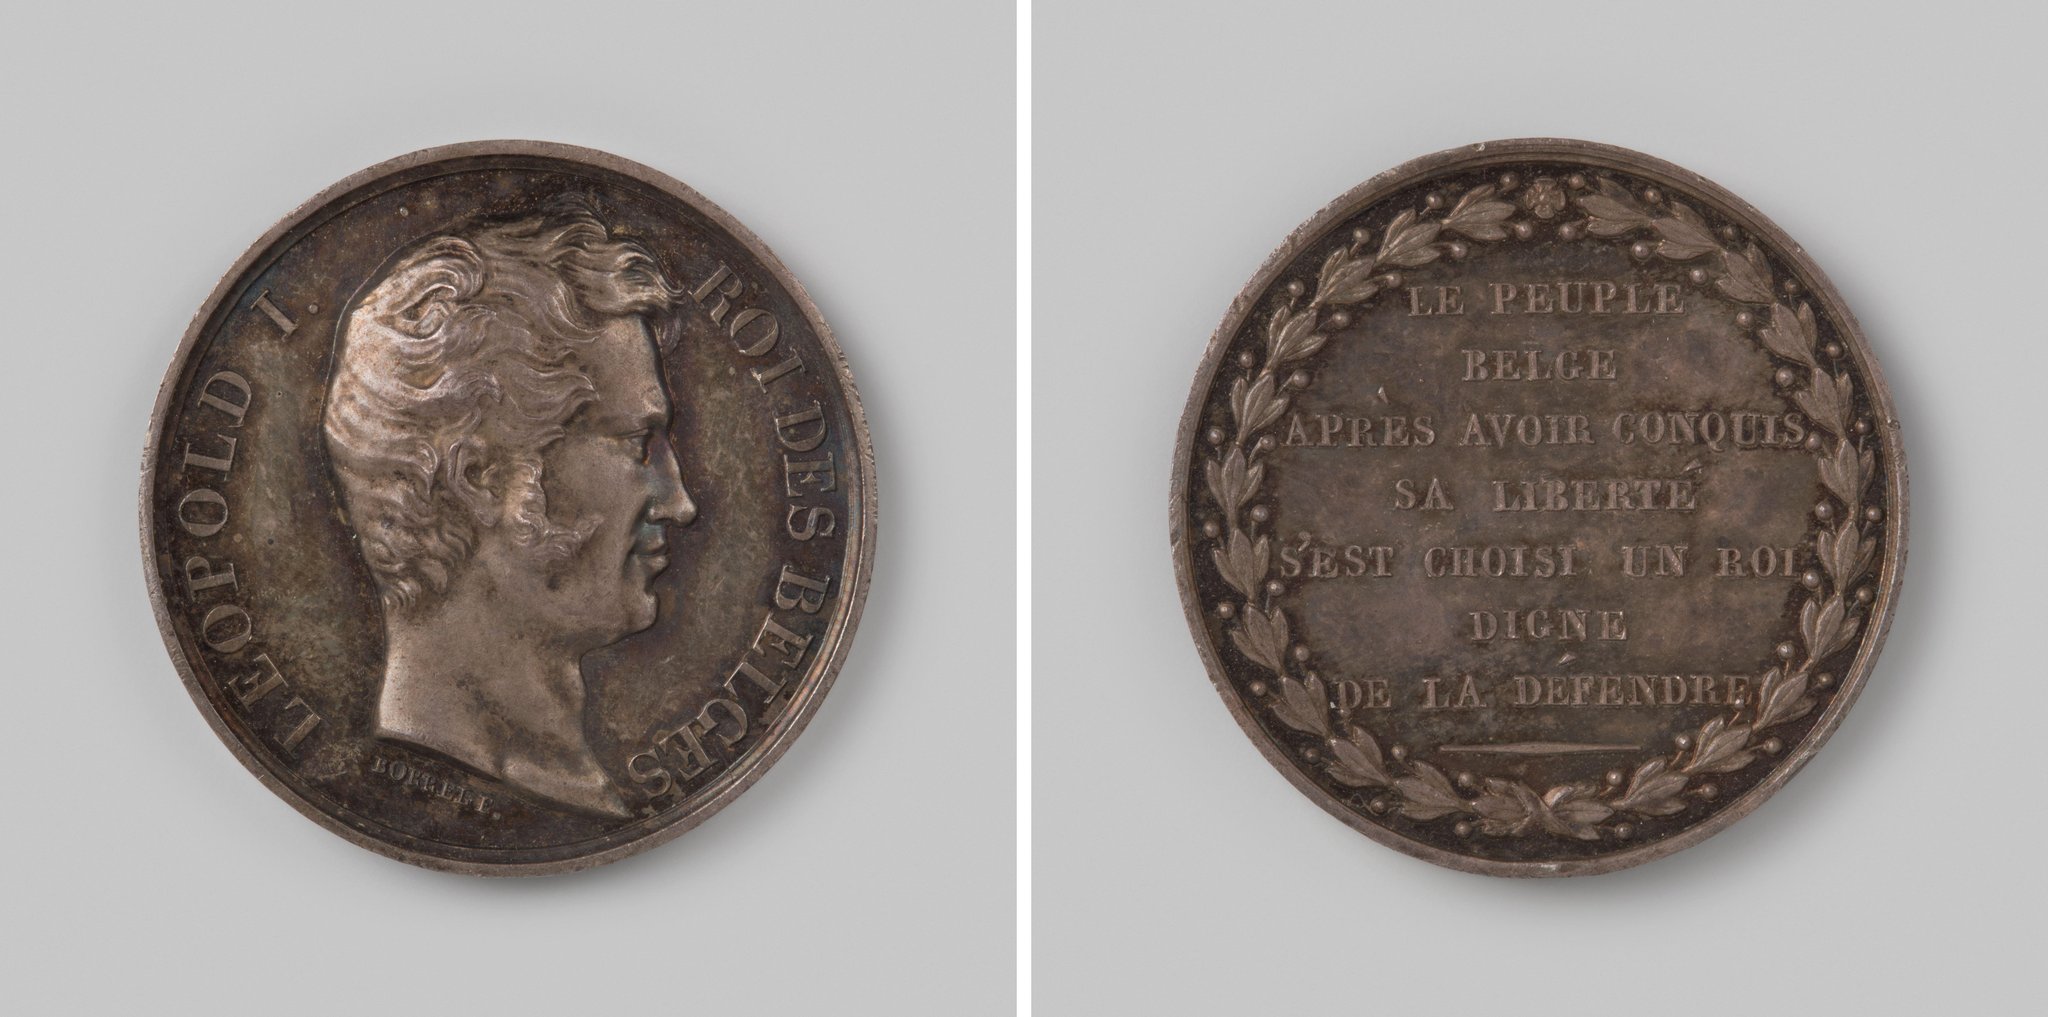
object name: history medal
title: Leopold van Saksen-Coburg door het Nationaal Congres verkozen tot koning van België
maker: m. borrel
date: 1831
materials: silver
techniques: striking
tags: laeken, leopold i (koning der belgen)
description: Zilveren penning. Voorzijde: borststuk man binnen omschrift. Keerzijde: opschrift binnen krans van olijftakken.